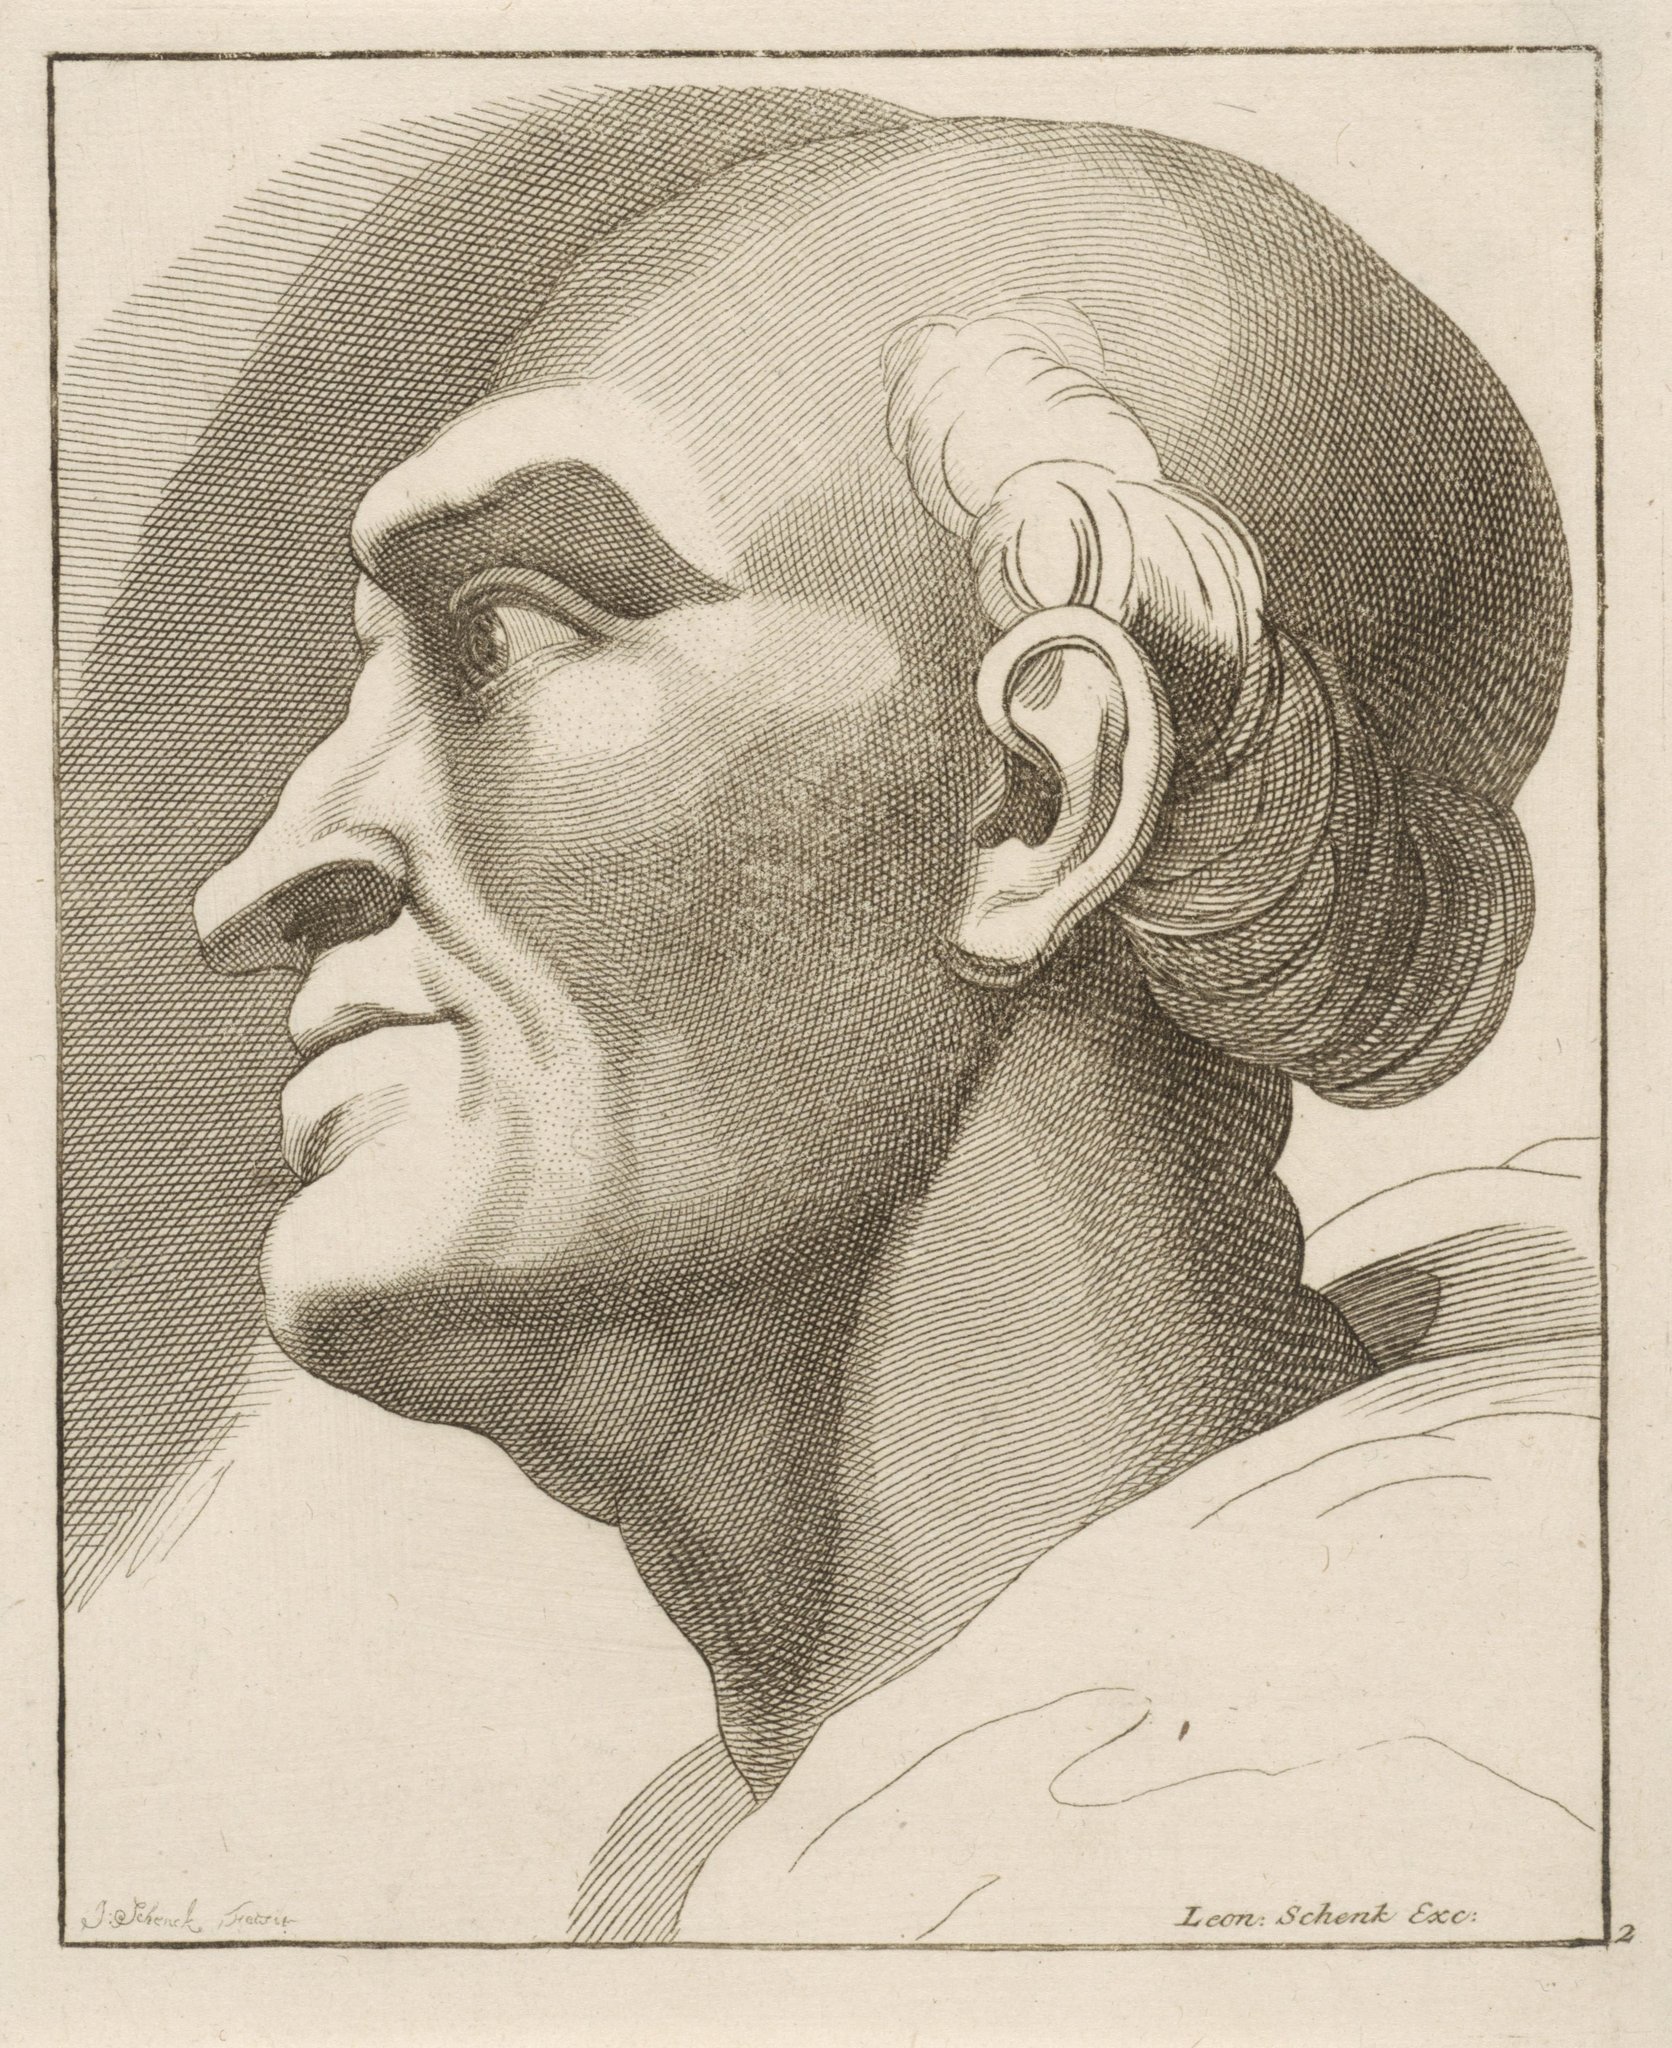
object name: print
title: Studies van menselijke hoofden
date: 1710-1767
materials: paper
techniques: engraving, etching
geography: amsterdam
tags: head (human) (+ left side visible; left - (l. hand, l. foot, etc.))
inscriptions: collector's mark: Lugt 2228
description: De prent is vervaardigd naar een figuur op de fresco's van de Sixtijnse Kapel.